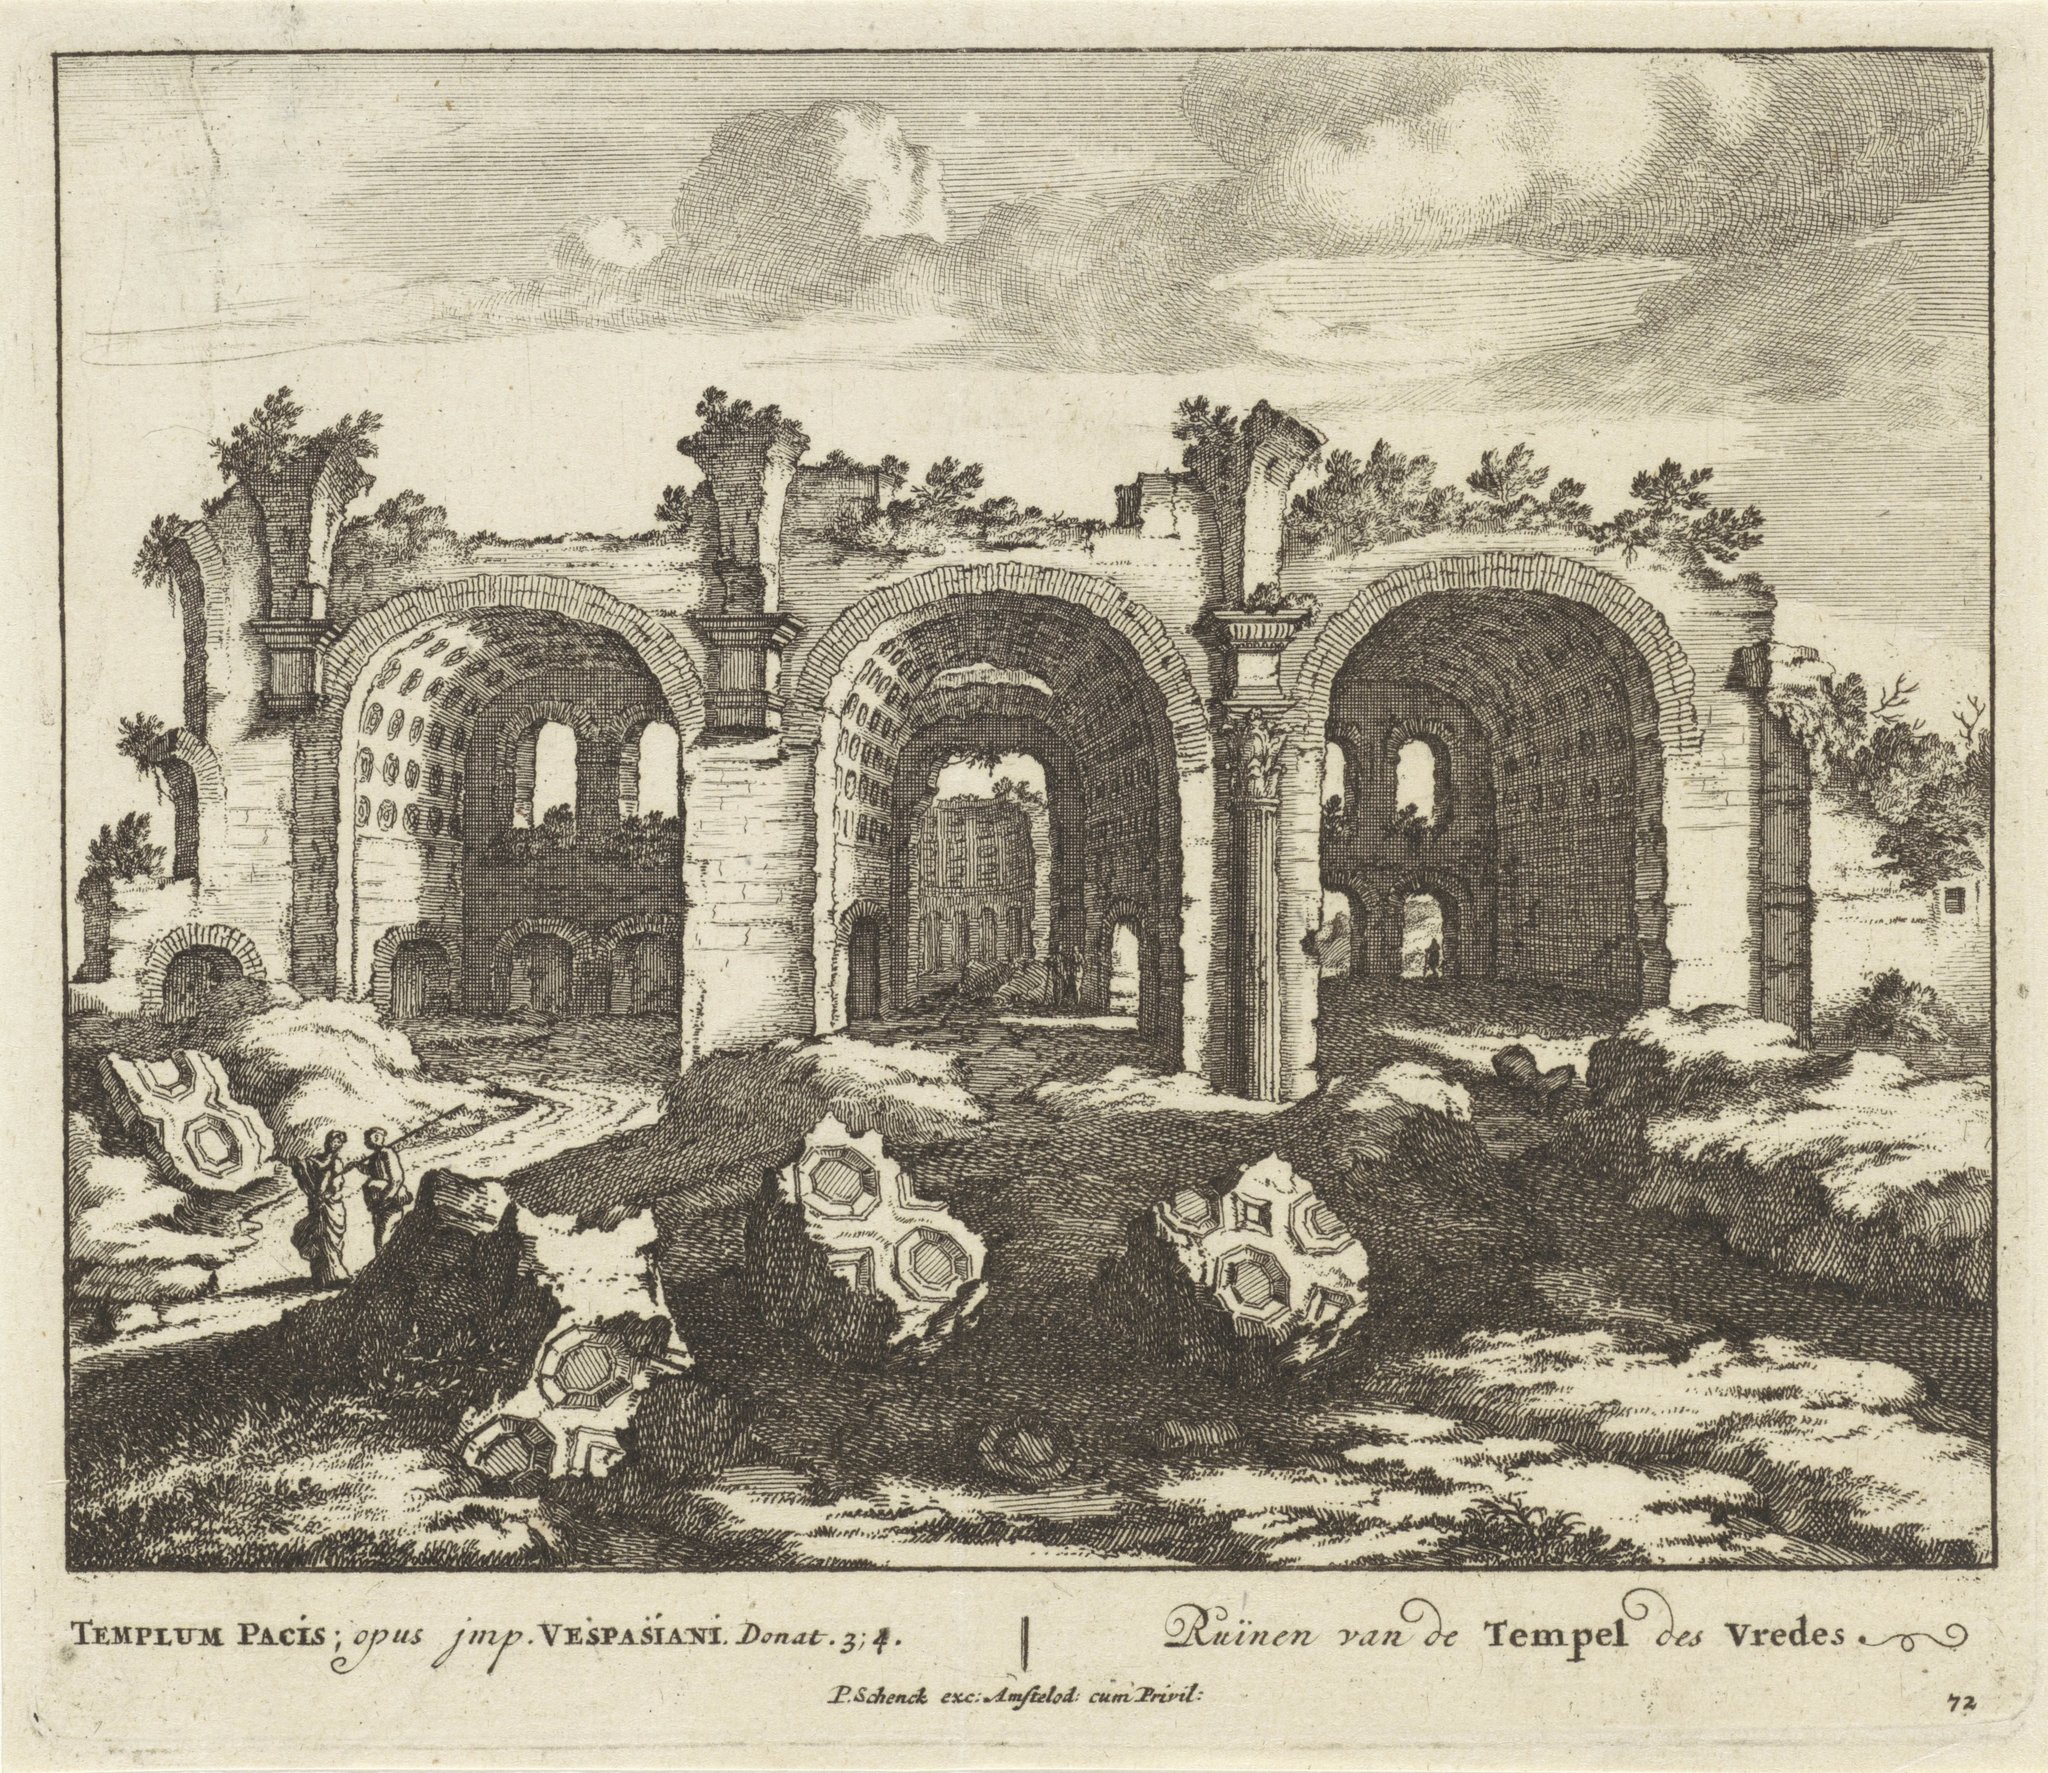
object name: print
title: Ruïne van de vredestempel te Rome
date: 1675-1711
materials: paper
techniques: etching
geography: amsterdam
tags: tempio della pace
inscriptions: collector's mark: Lugt 2228